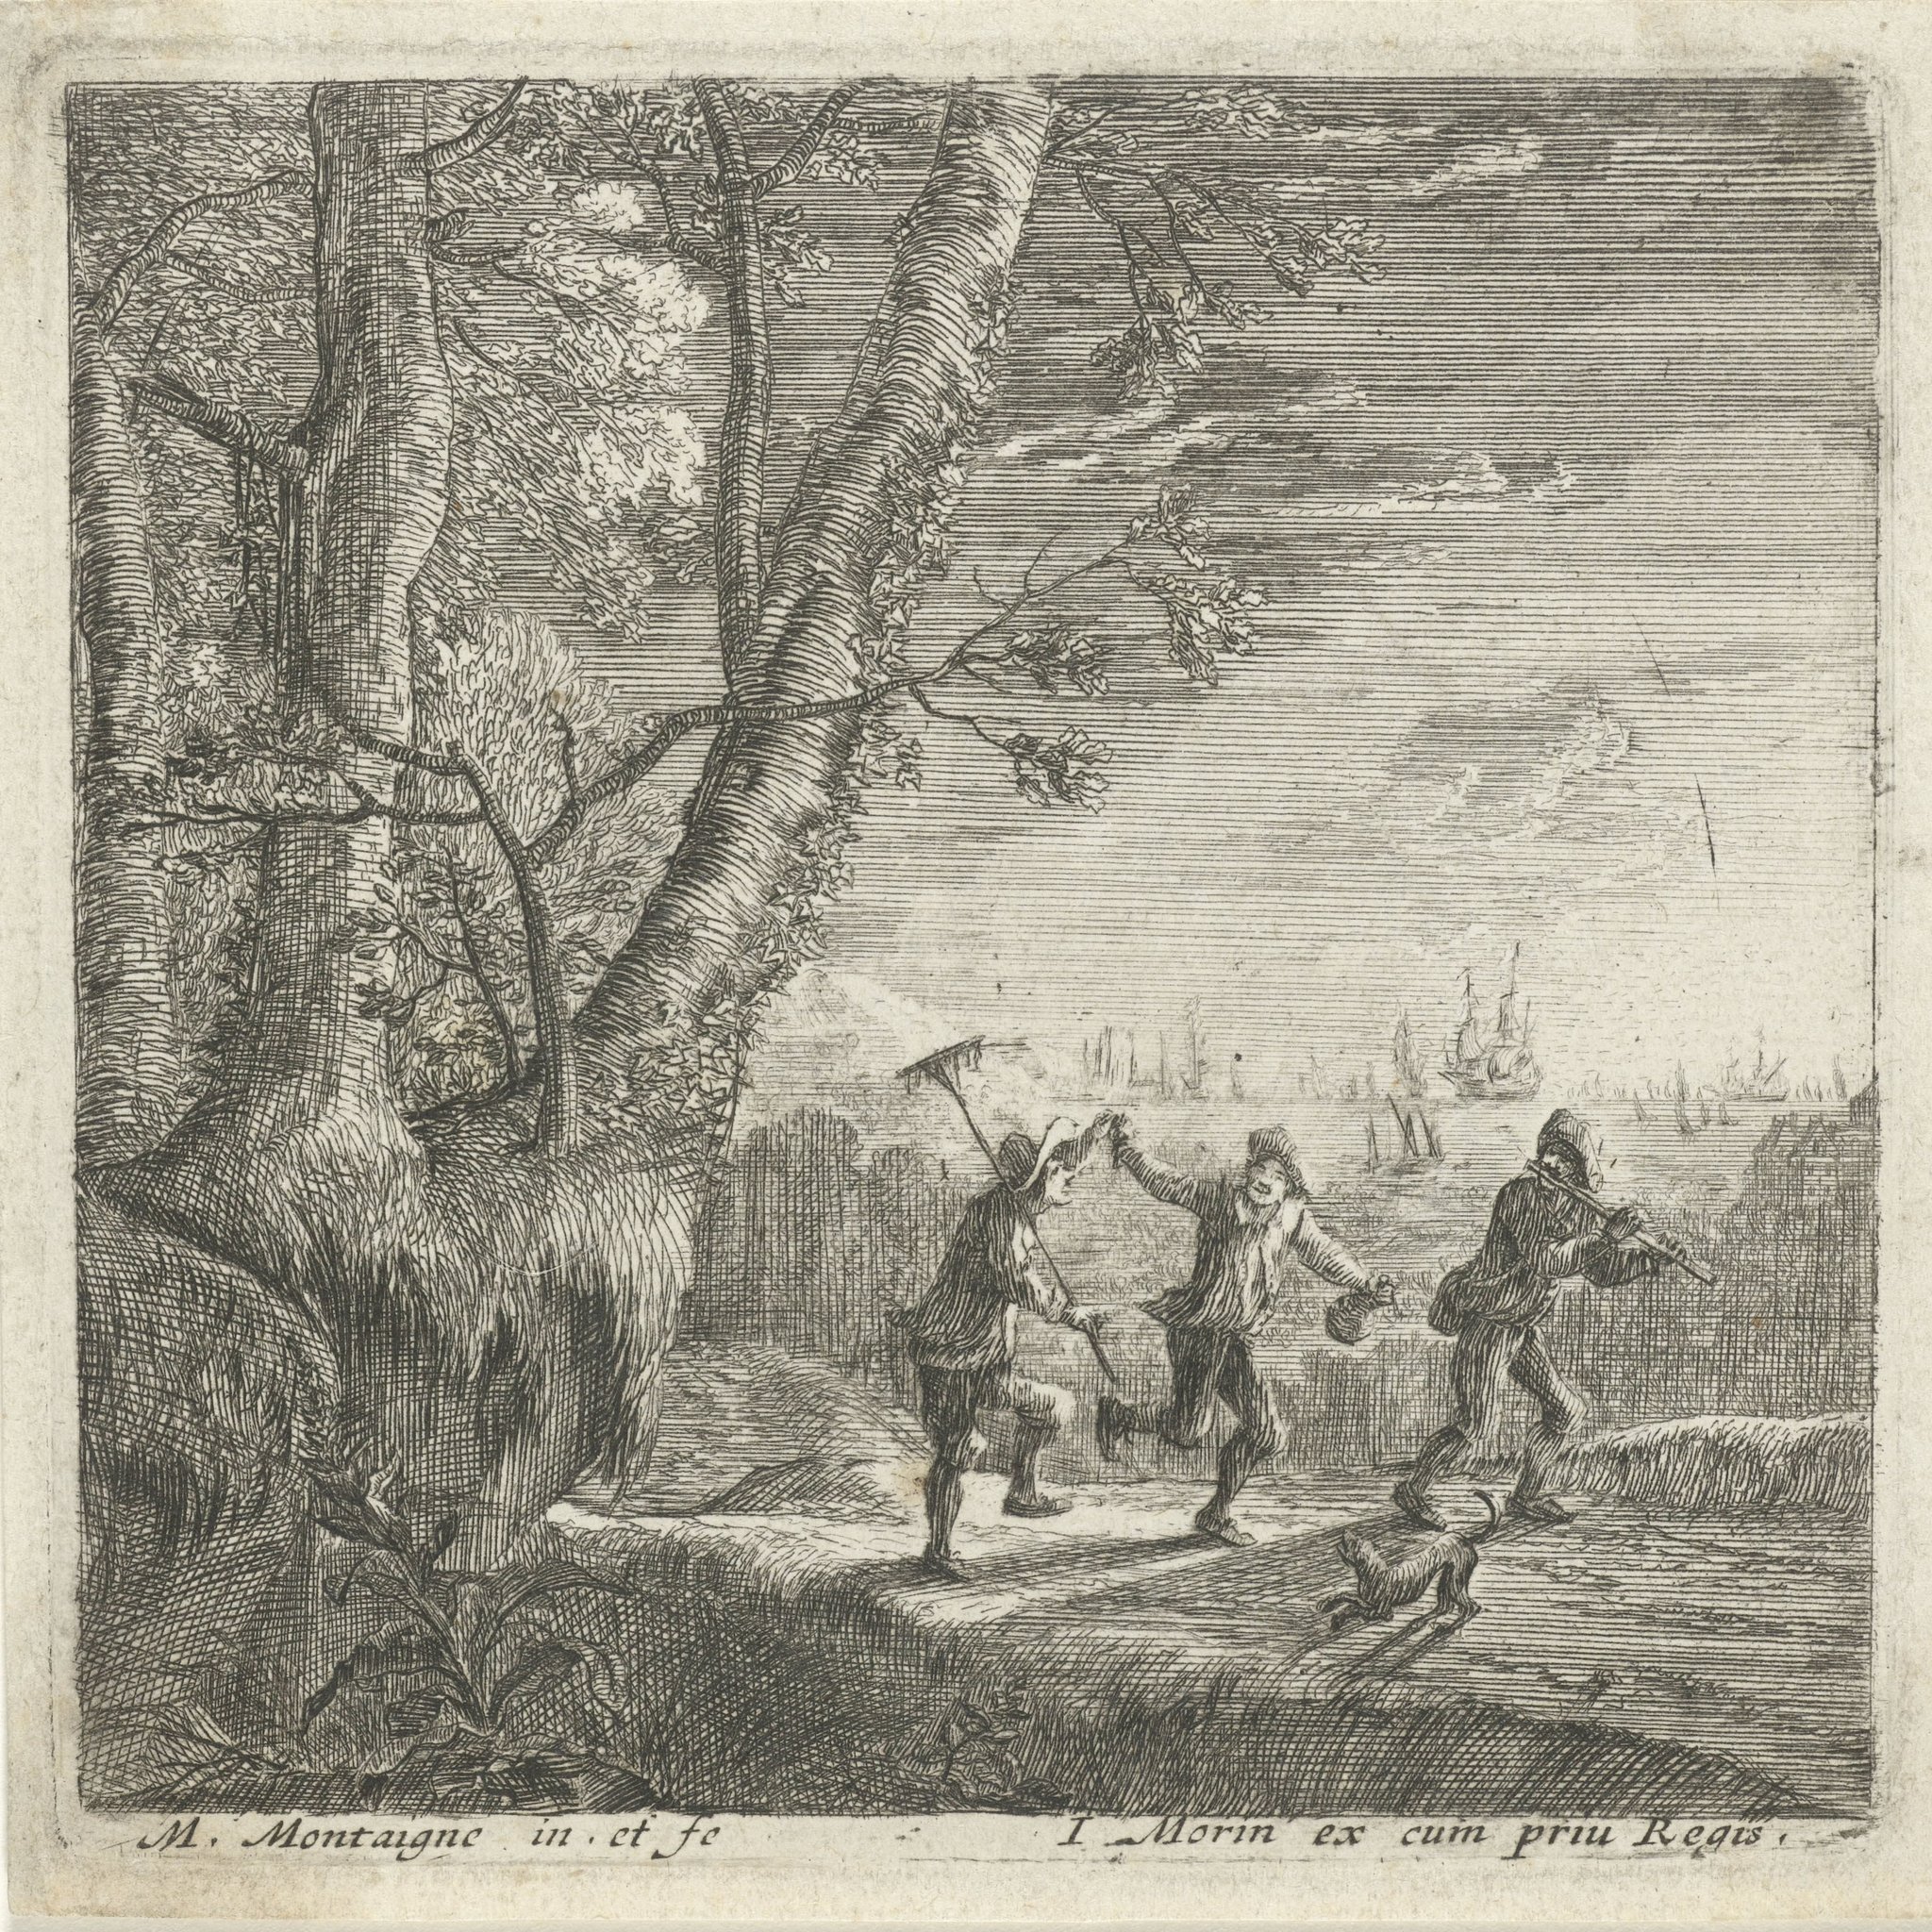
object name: print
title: Landschap met drie dansende boeren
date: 1617-1660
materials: paper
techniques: engraving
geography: paris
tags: dancing, farmers, coast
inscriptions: collector's mark: Lugt 2228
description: Drie boeren lopen op een pad langs de kust. Ze dansen en één van hen bespeelt een fluit. Voor hen een hond.